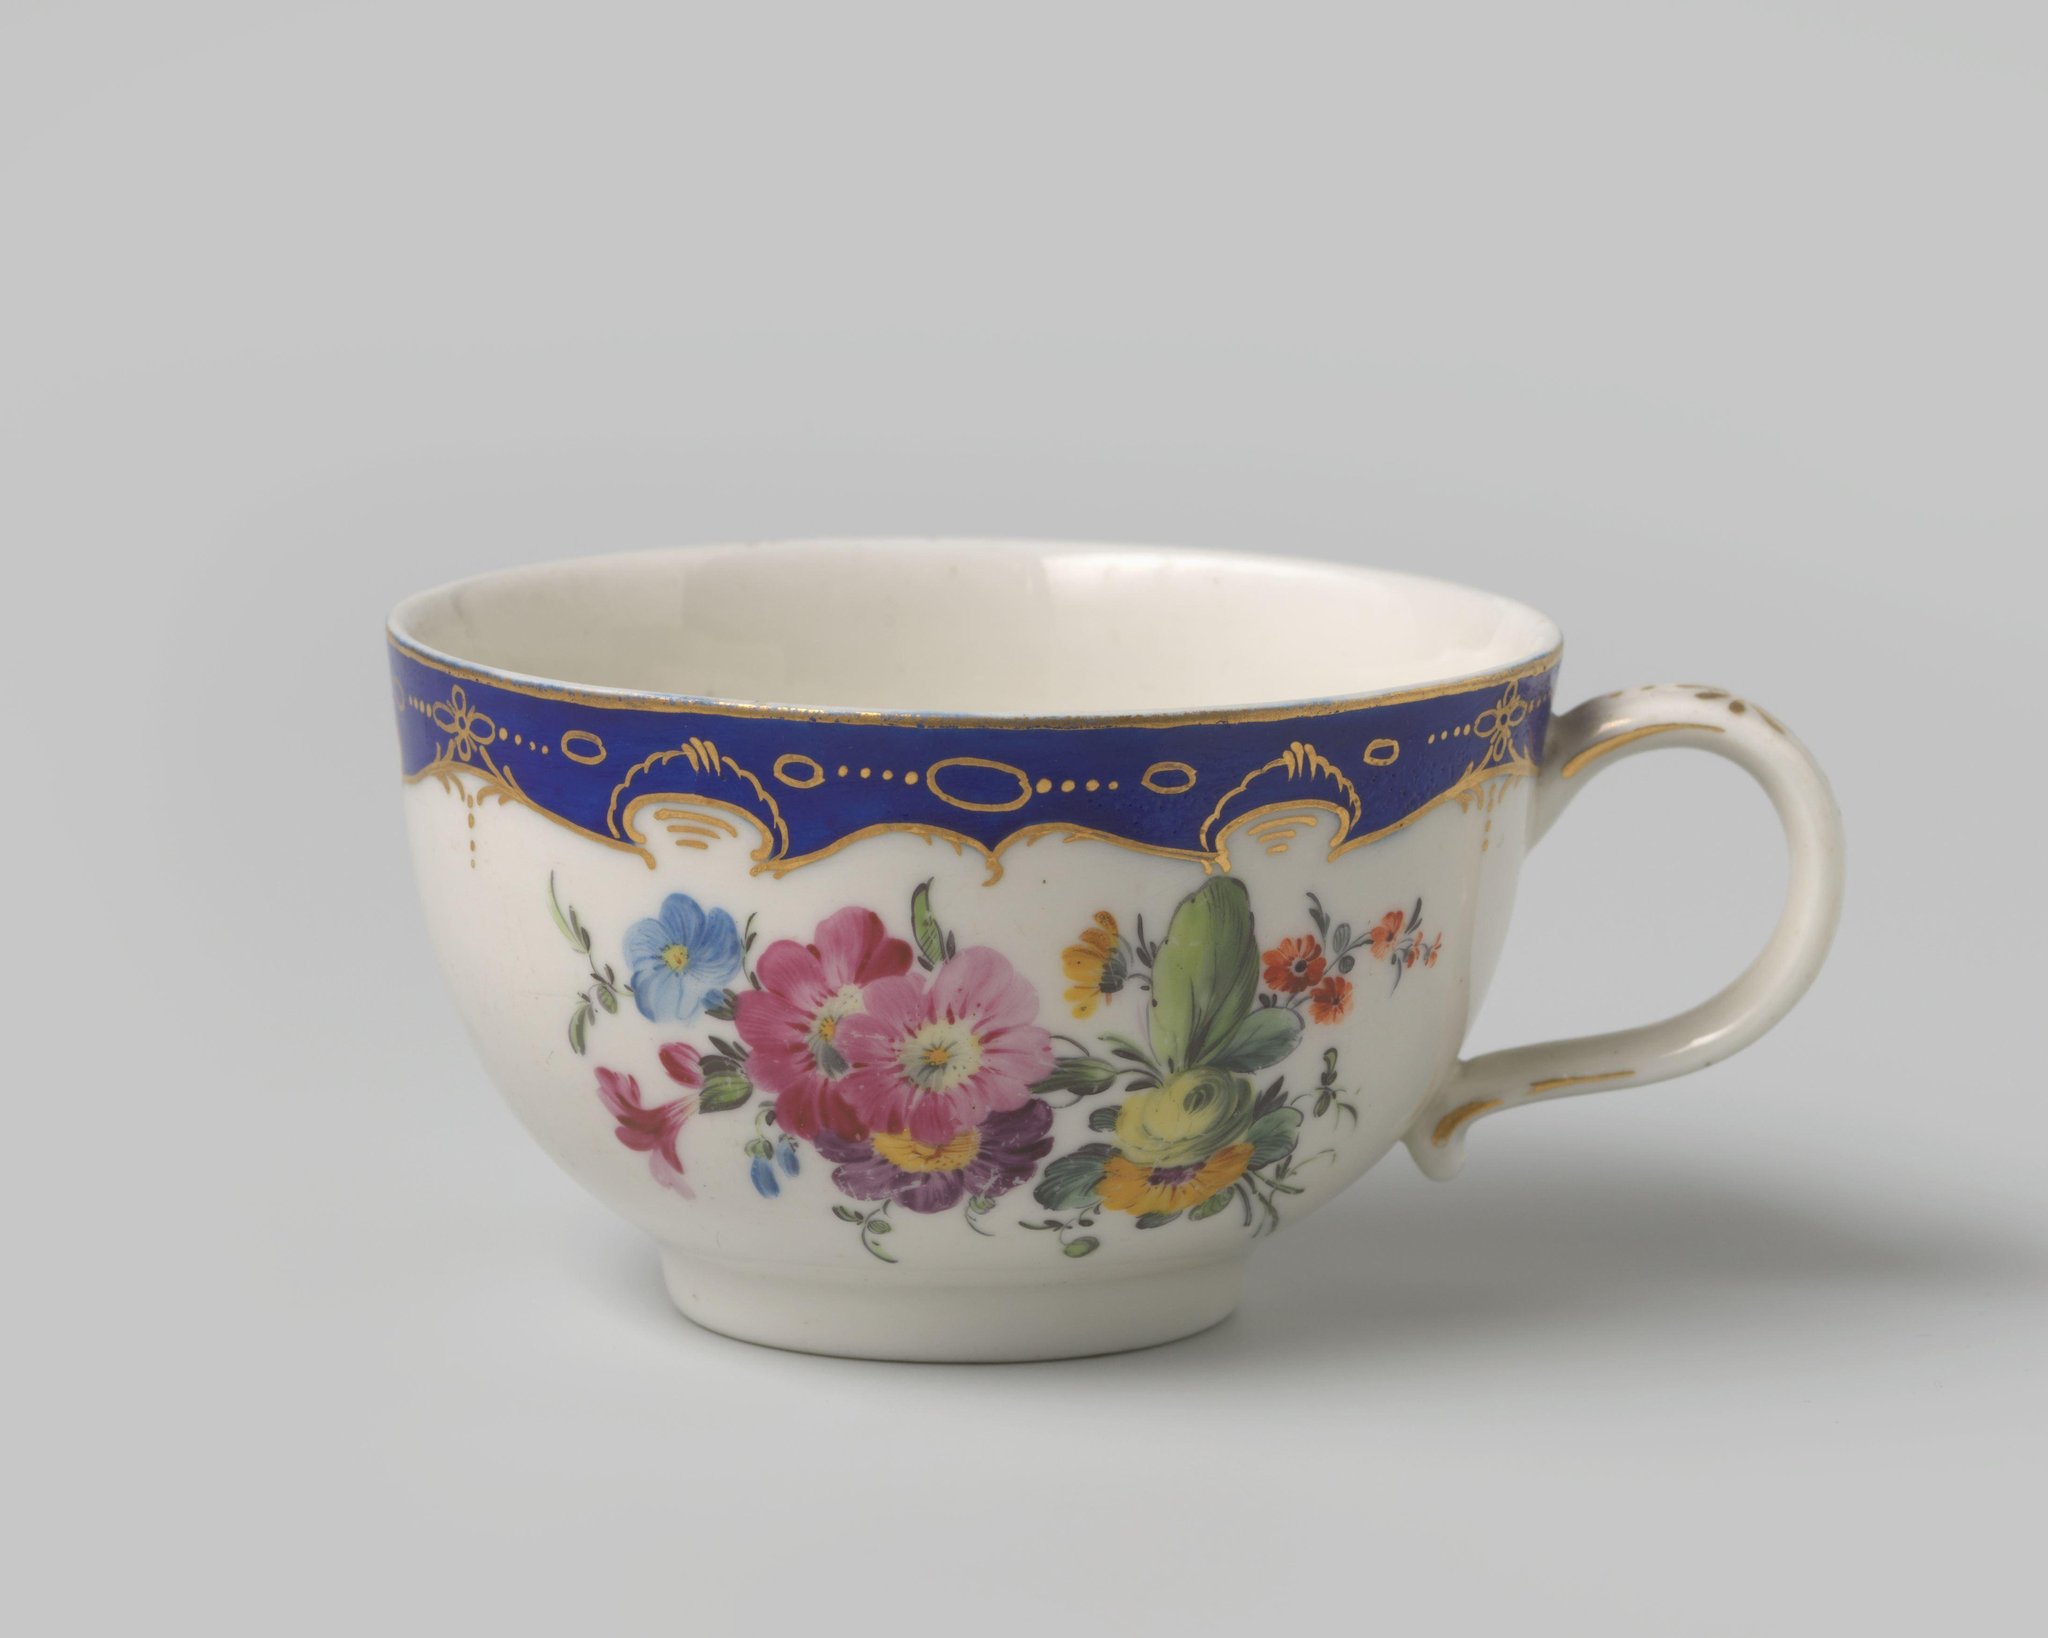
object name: cup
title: Kop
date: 1777-1790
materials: porcelain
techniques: painted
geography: the hague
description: Kop, onderdeel van theeservies. Op de rand een blauwe band met rocaille ornament. Het hoofdmotief bestaat uit een bloemboeket omgeven door strooibloemen. Gemerkt met een ooievaar in bovenglazuurblauw. N.B. Doorniks zacht porselein beschilderd te Den Haag.